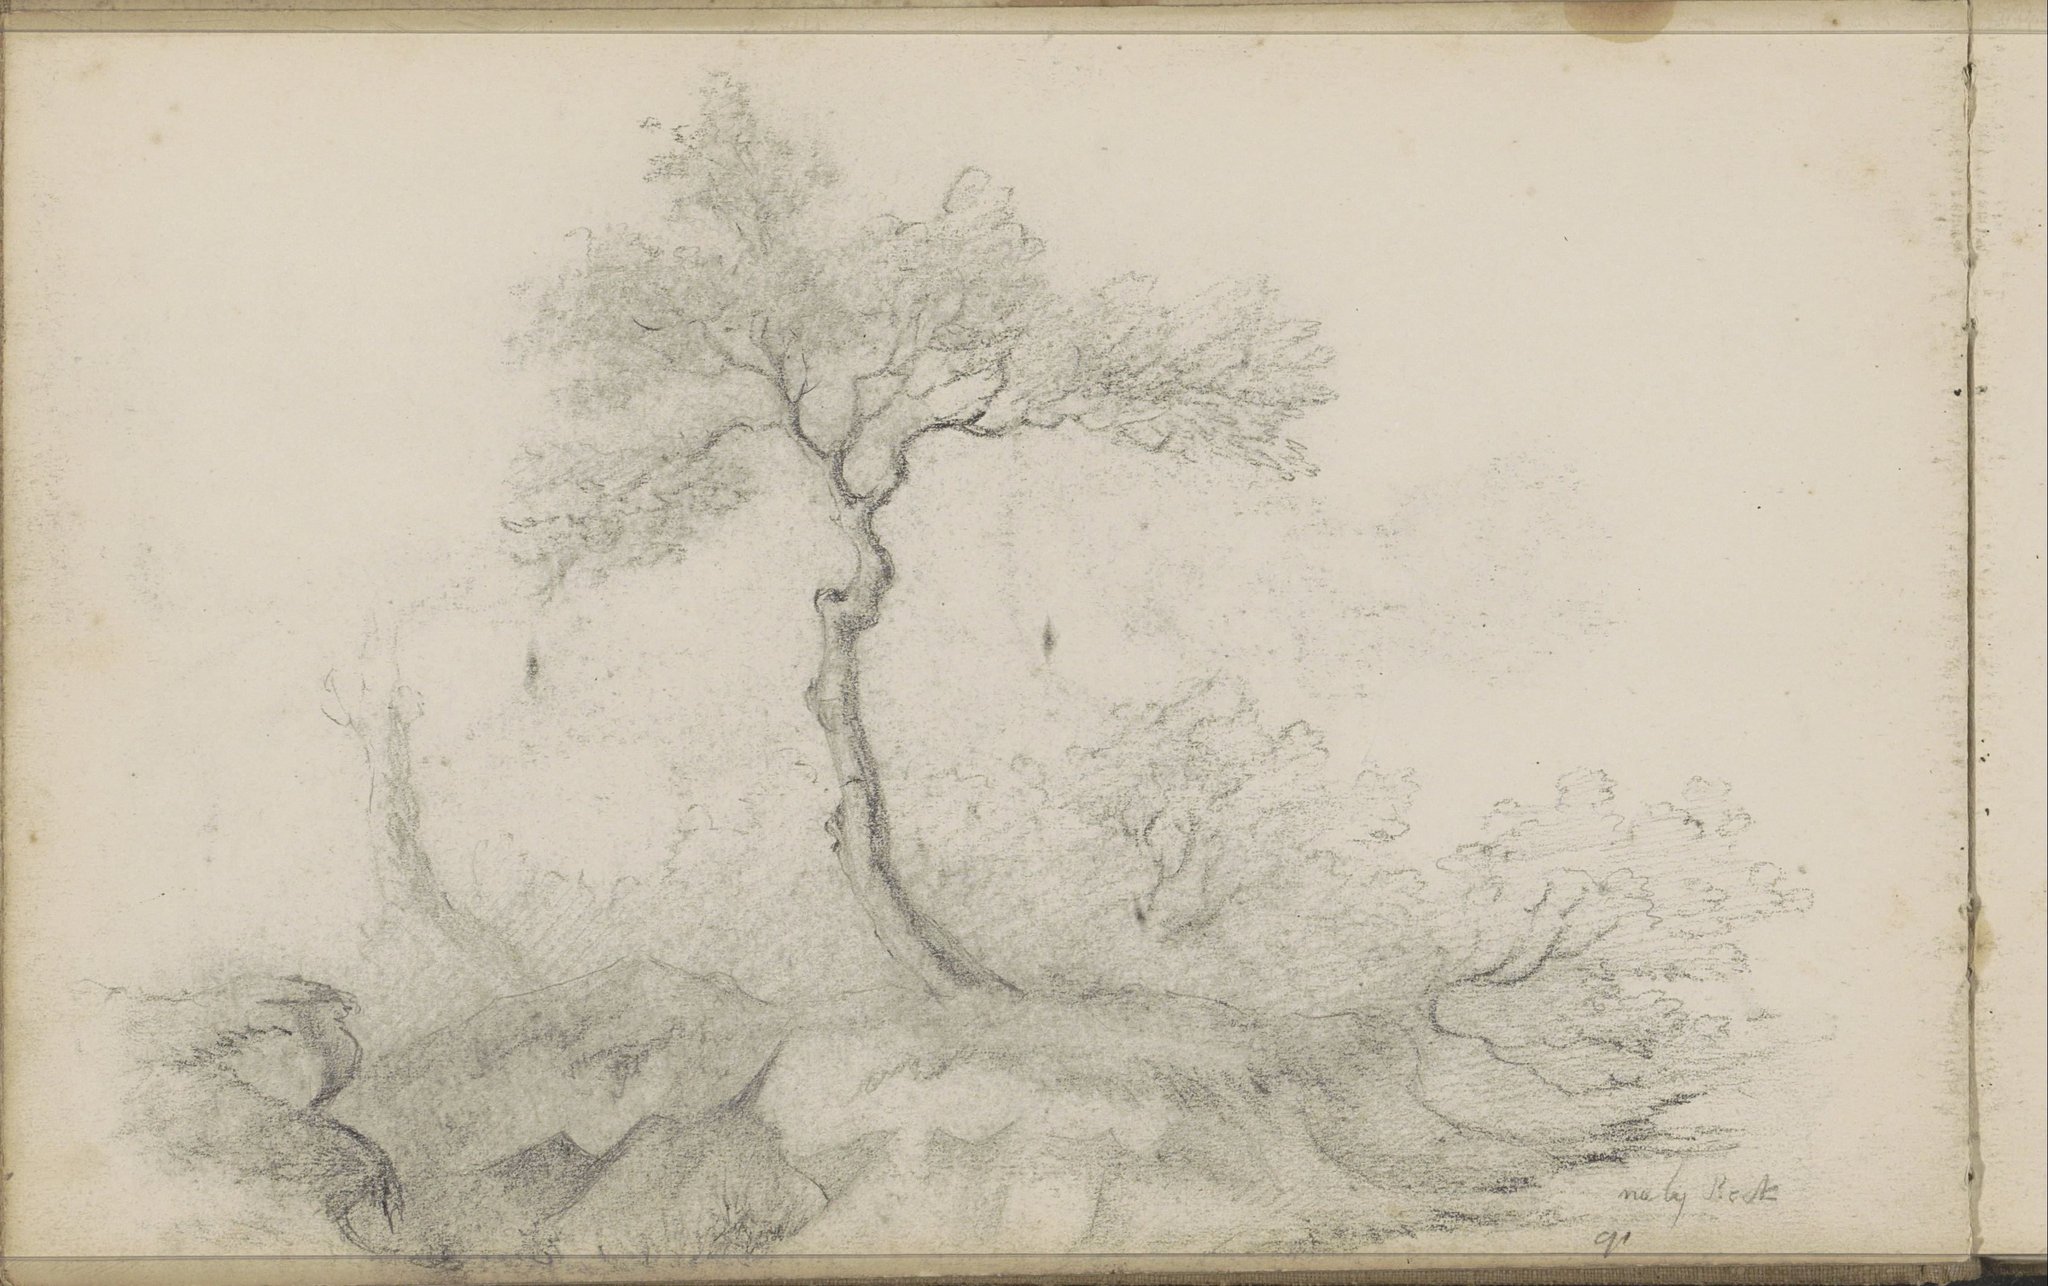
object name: sketchbook leaf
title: Boom op een heuvel bij Beek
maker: willem cornelis rip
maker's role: draughtsman, painter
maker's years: 1856-1922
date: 1874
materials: paper, pencil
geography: beek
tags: trees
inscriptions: annotation: ‘na bij Beek/ [...]’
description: Blad 6 verso uit een schetsboek met 47 bladen.